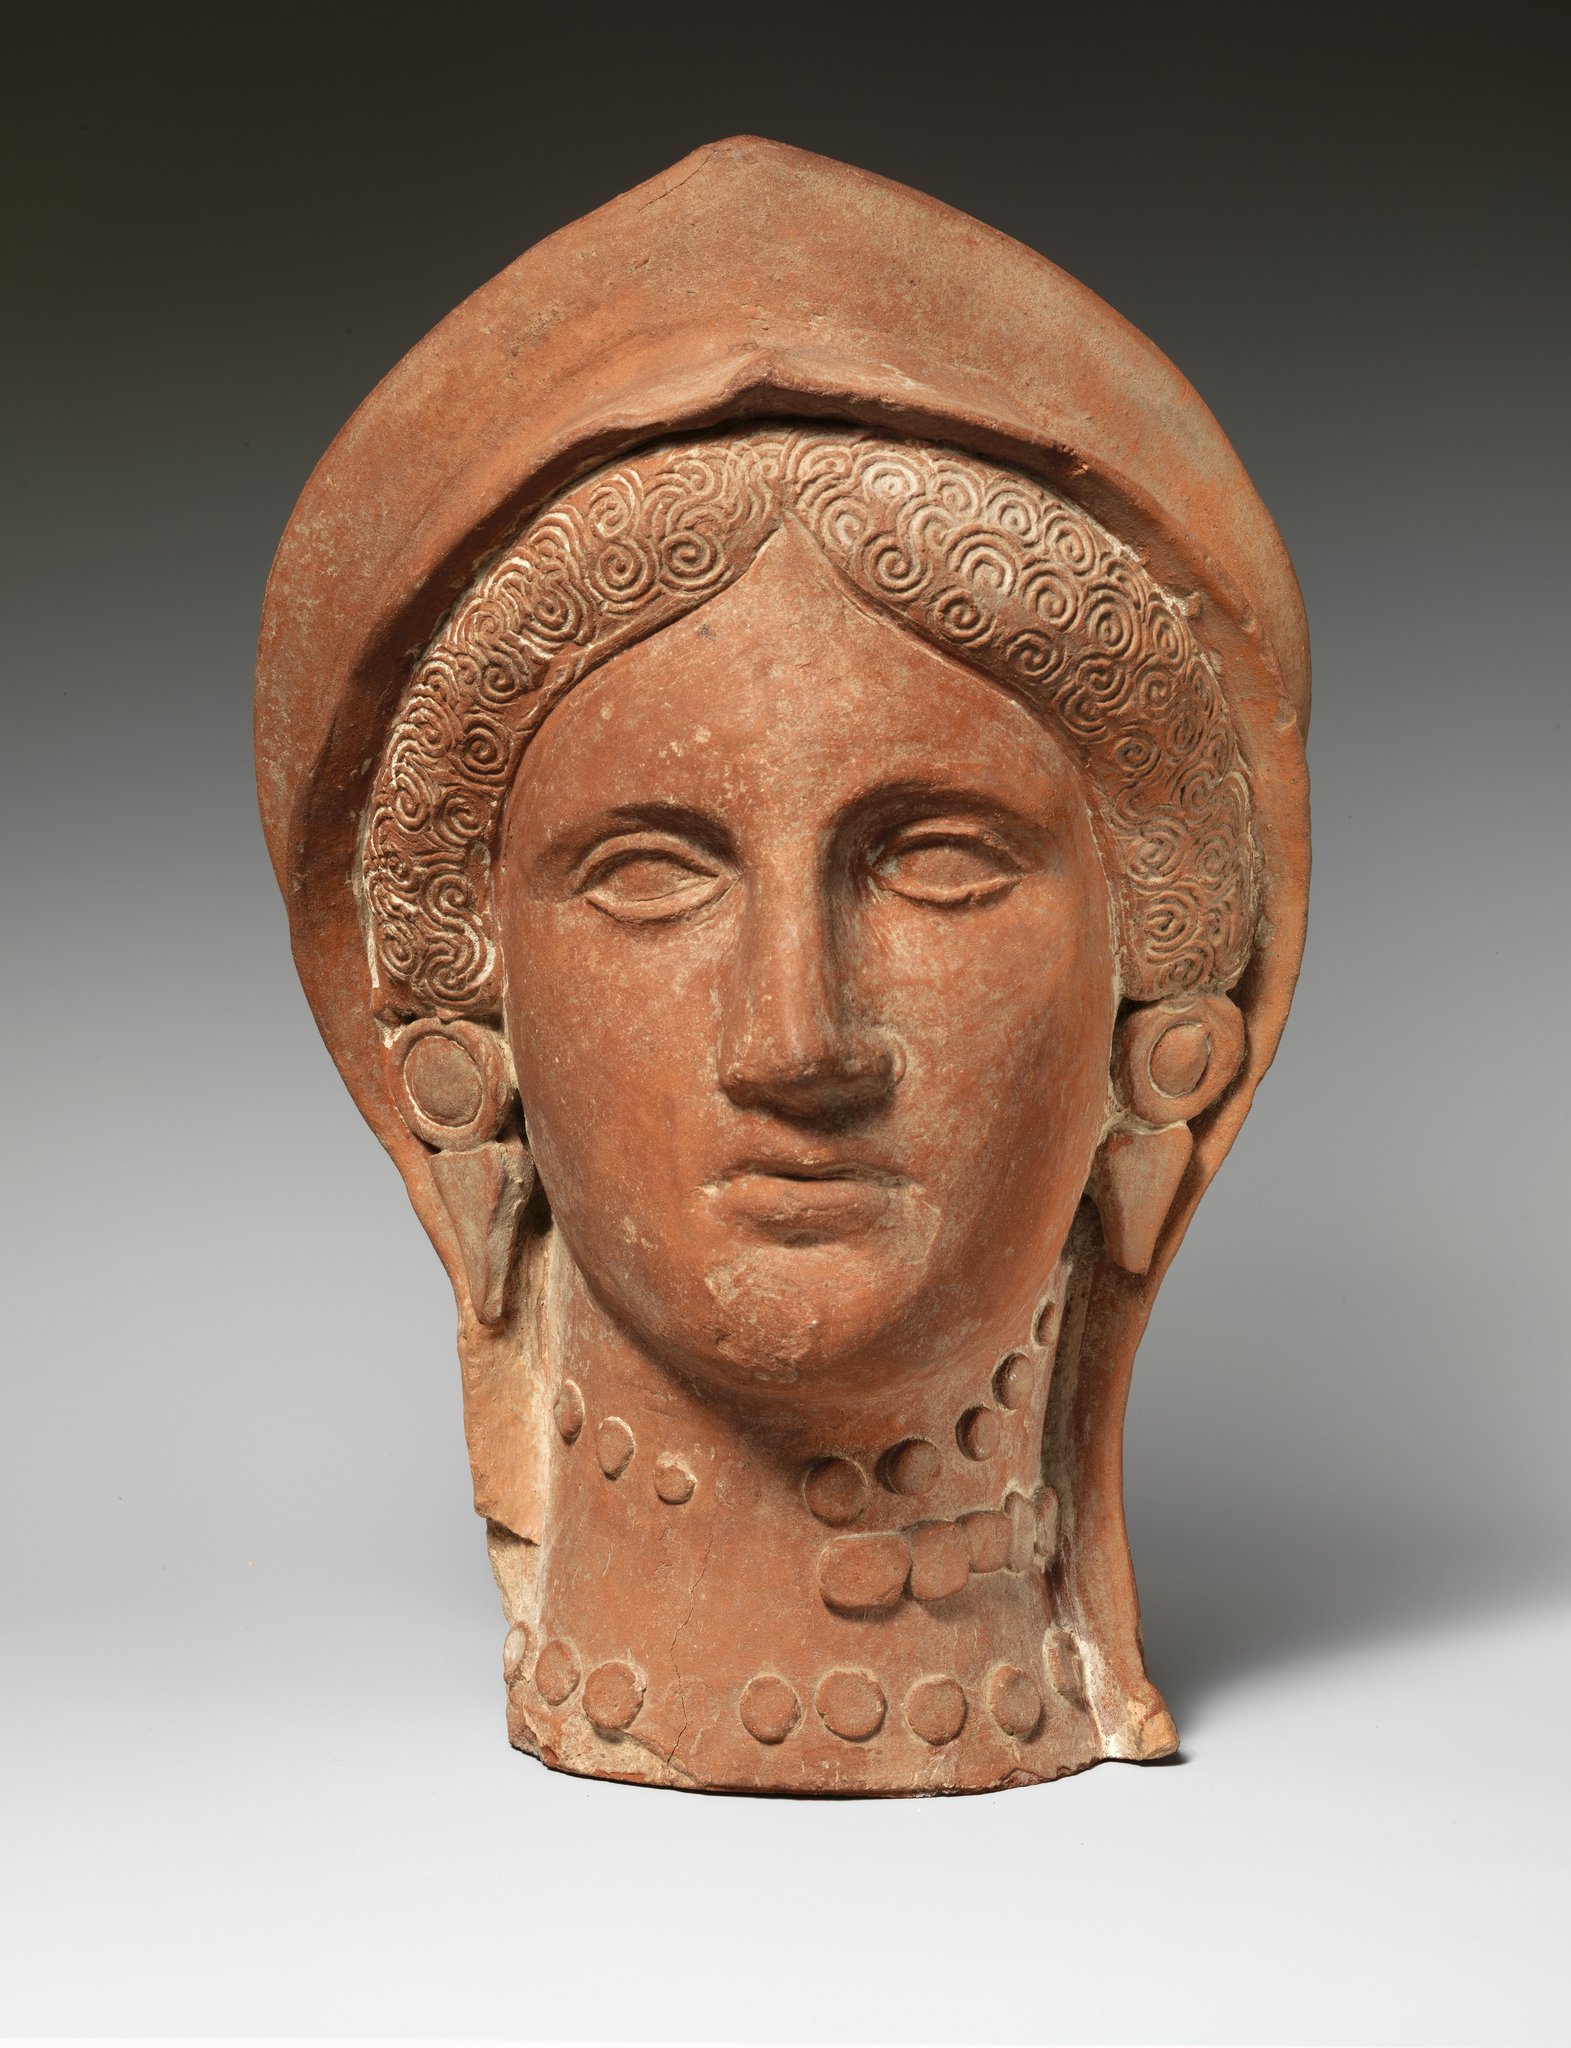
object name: head of a woman wearing stephane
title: Terracotta head of a woman wearing a stephane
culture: cypriot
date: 400-310 BCE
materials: terracotta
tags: heads,women